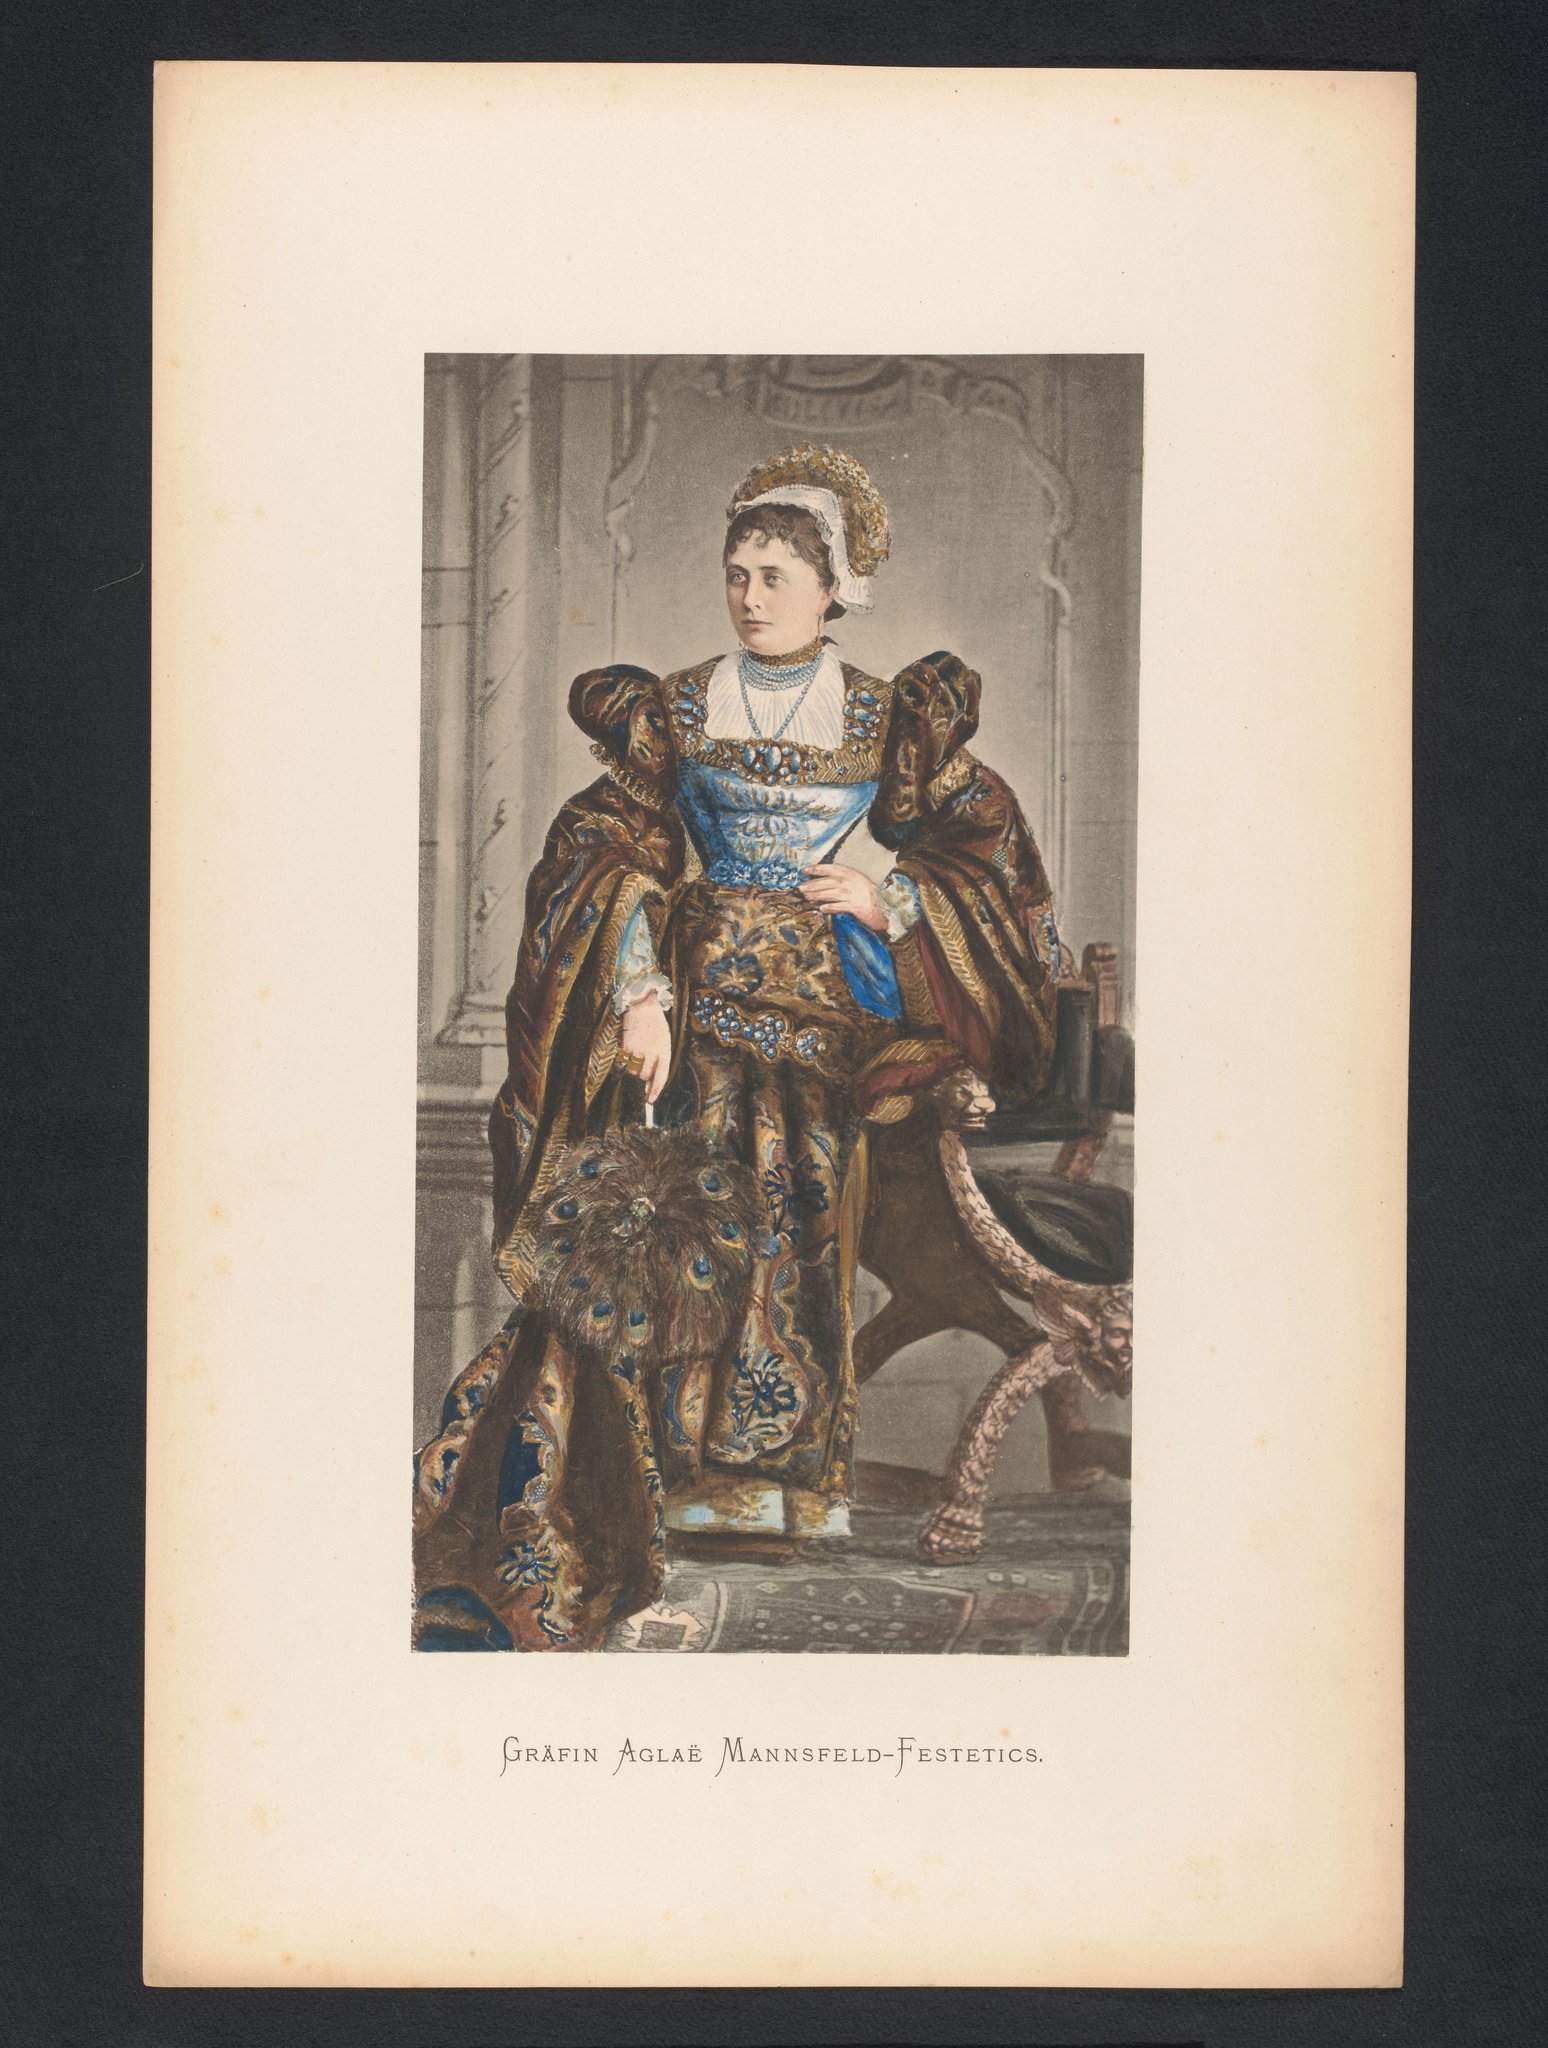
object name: photomechanical print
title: Gräfin Aglaë Mannsfeld-Festetics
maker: Anonymous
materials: paper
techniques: photograph, hand coloring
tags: vienna, historical persons - bb - woman, aristocracy; 'aristocratia' (ripa)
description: Deze prent maakt deel uit van een omslag met 86 prenten op 78 bladen en 11 tekstbladen.